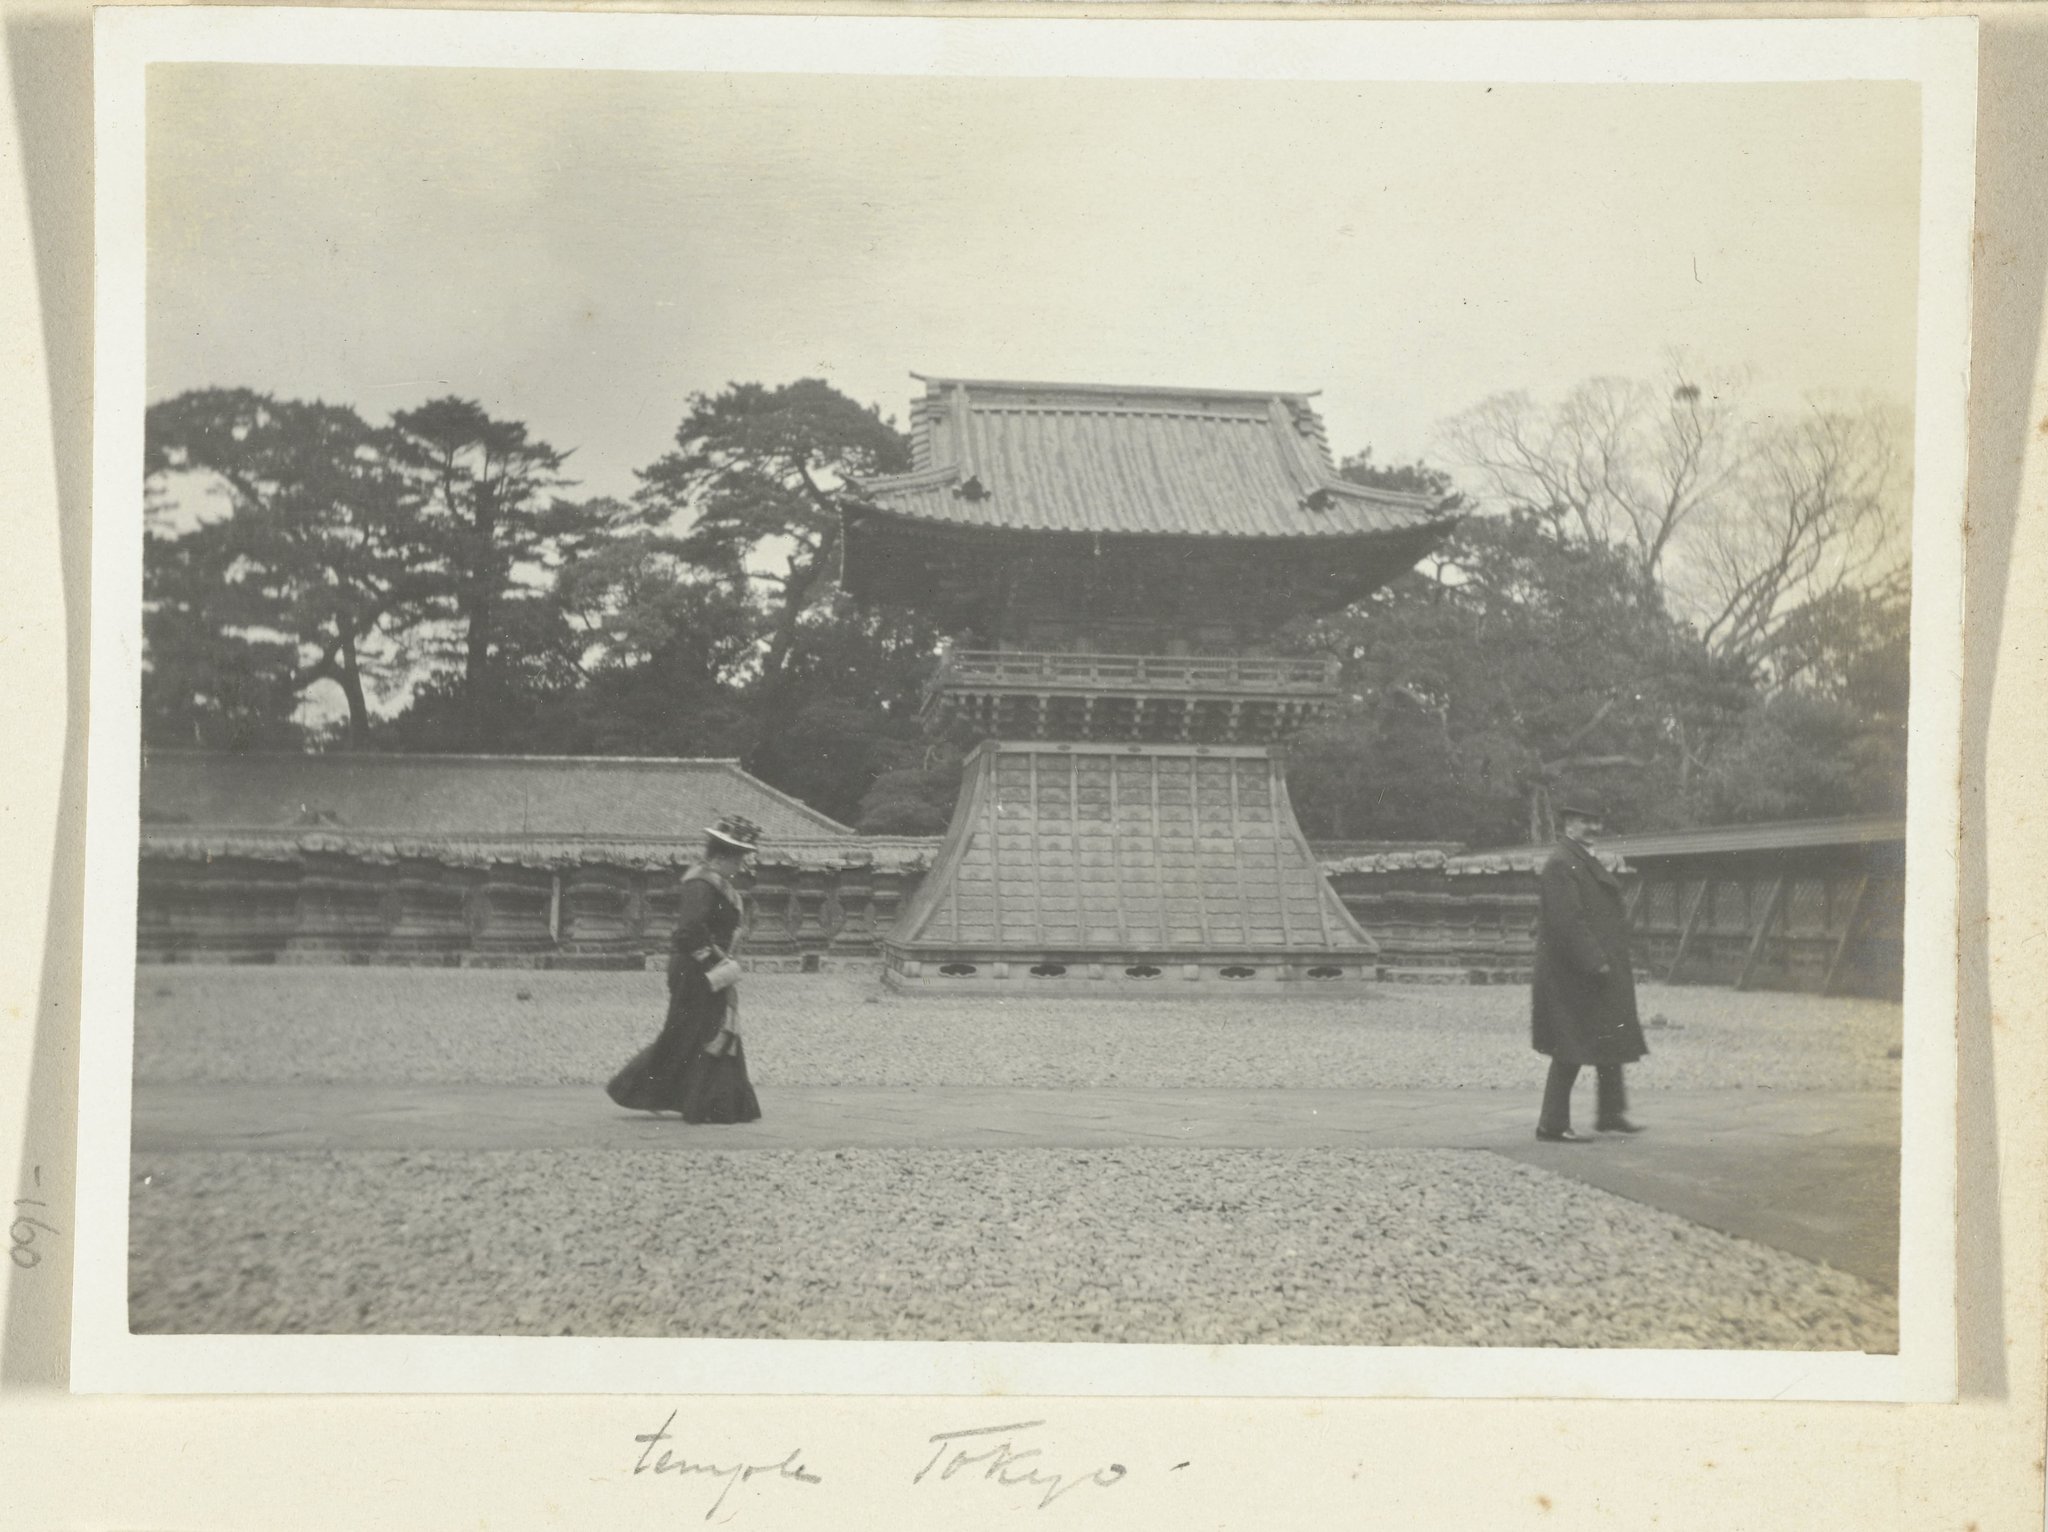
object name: photograph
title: Temple Tokyo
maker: geldolph adriaan kessler (dolph)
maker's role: fotograaf, industrieel, voetballer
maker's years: 1884-1945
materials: cardboard, photographic support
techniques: gelatin silver print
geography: tokyo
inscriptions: title: ‘Tokyo temple’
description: Reisgenoten van Dolph Kessler bij een tempel in Tokyo. Onderdeel van het fotoalbum van Dolph Kessler met opnamen die hij maakte tijdens zijn verblijf in Engeland en op een wereldreis die hij als secretaris van Henri Deterding (directeur Koninklijke Olie) ondernam naar Nederlands-Indië, Japan, China en de Verenigde Staten, tussen 1906 en 1908.